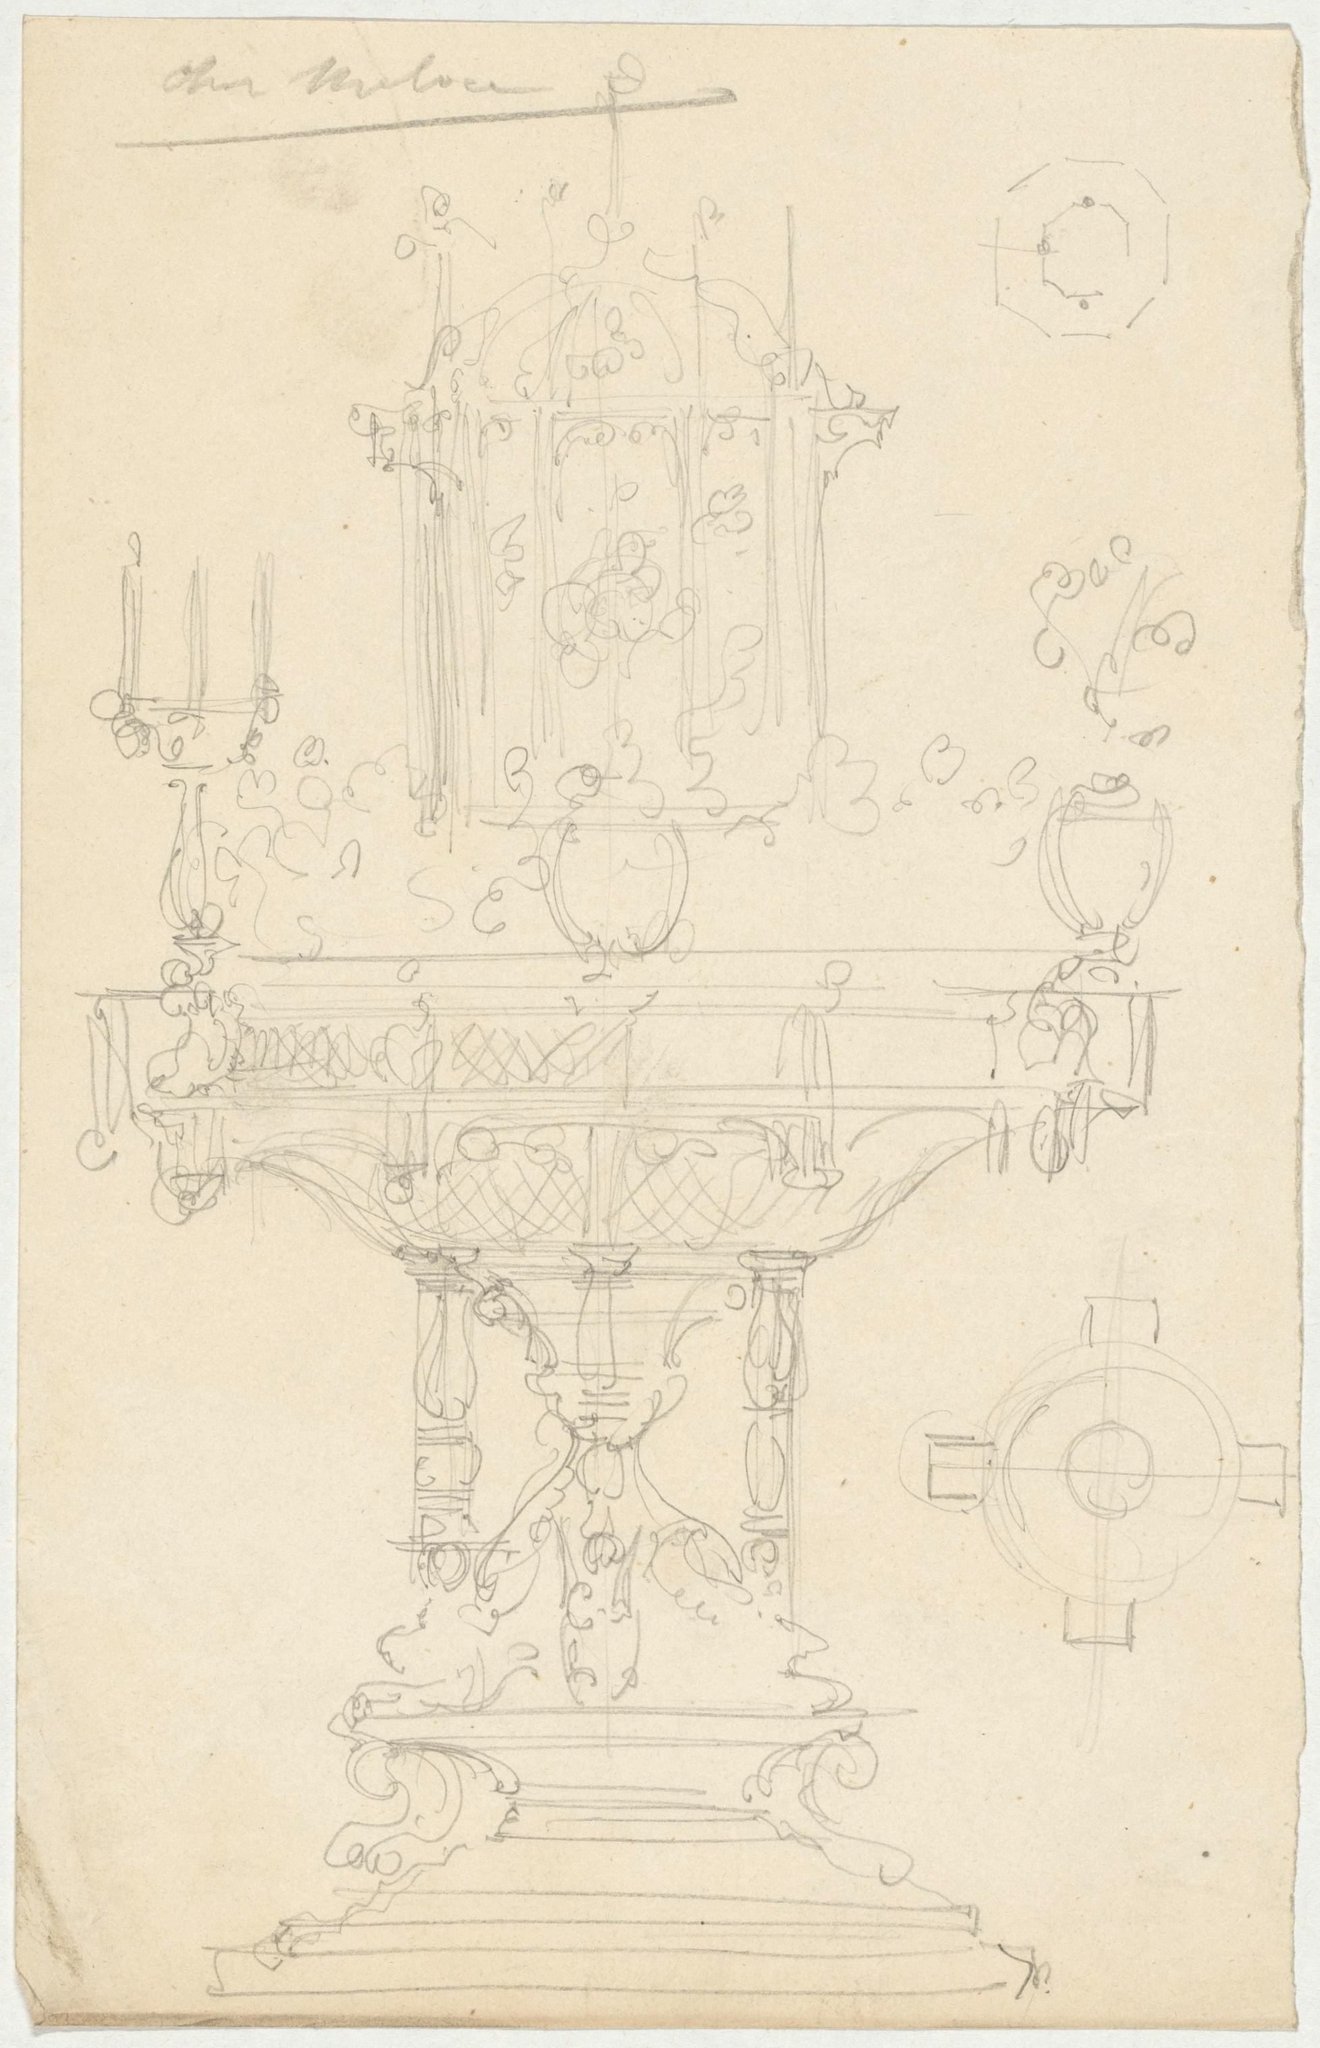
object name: design drawing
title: Tafelstuk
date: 1830-1850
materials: graphite, paper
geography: paris